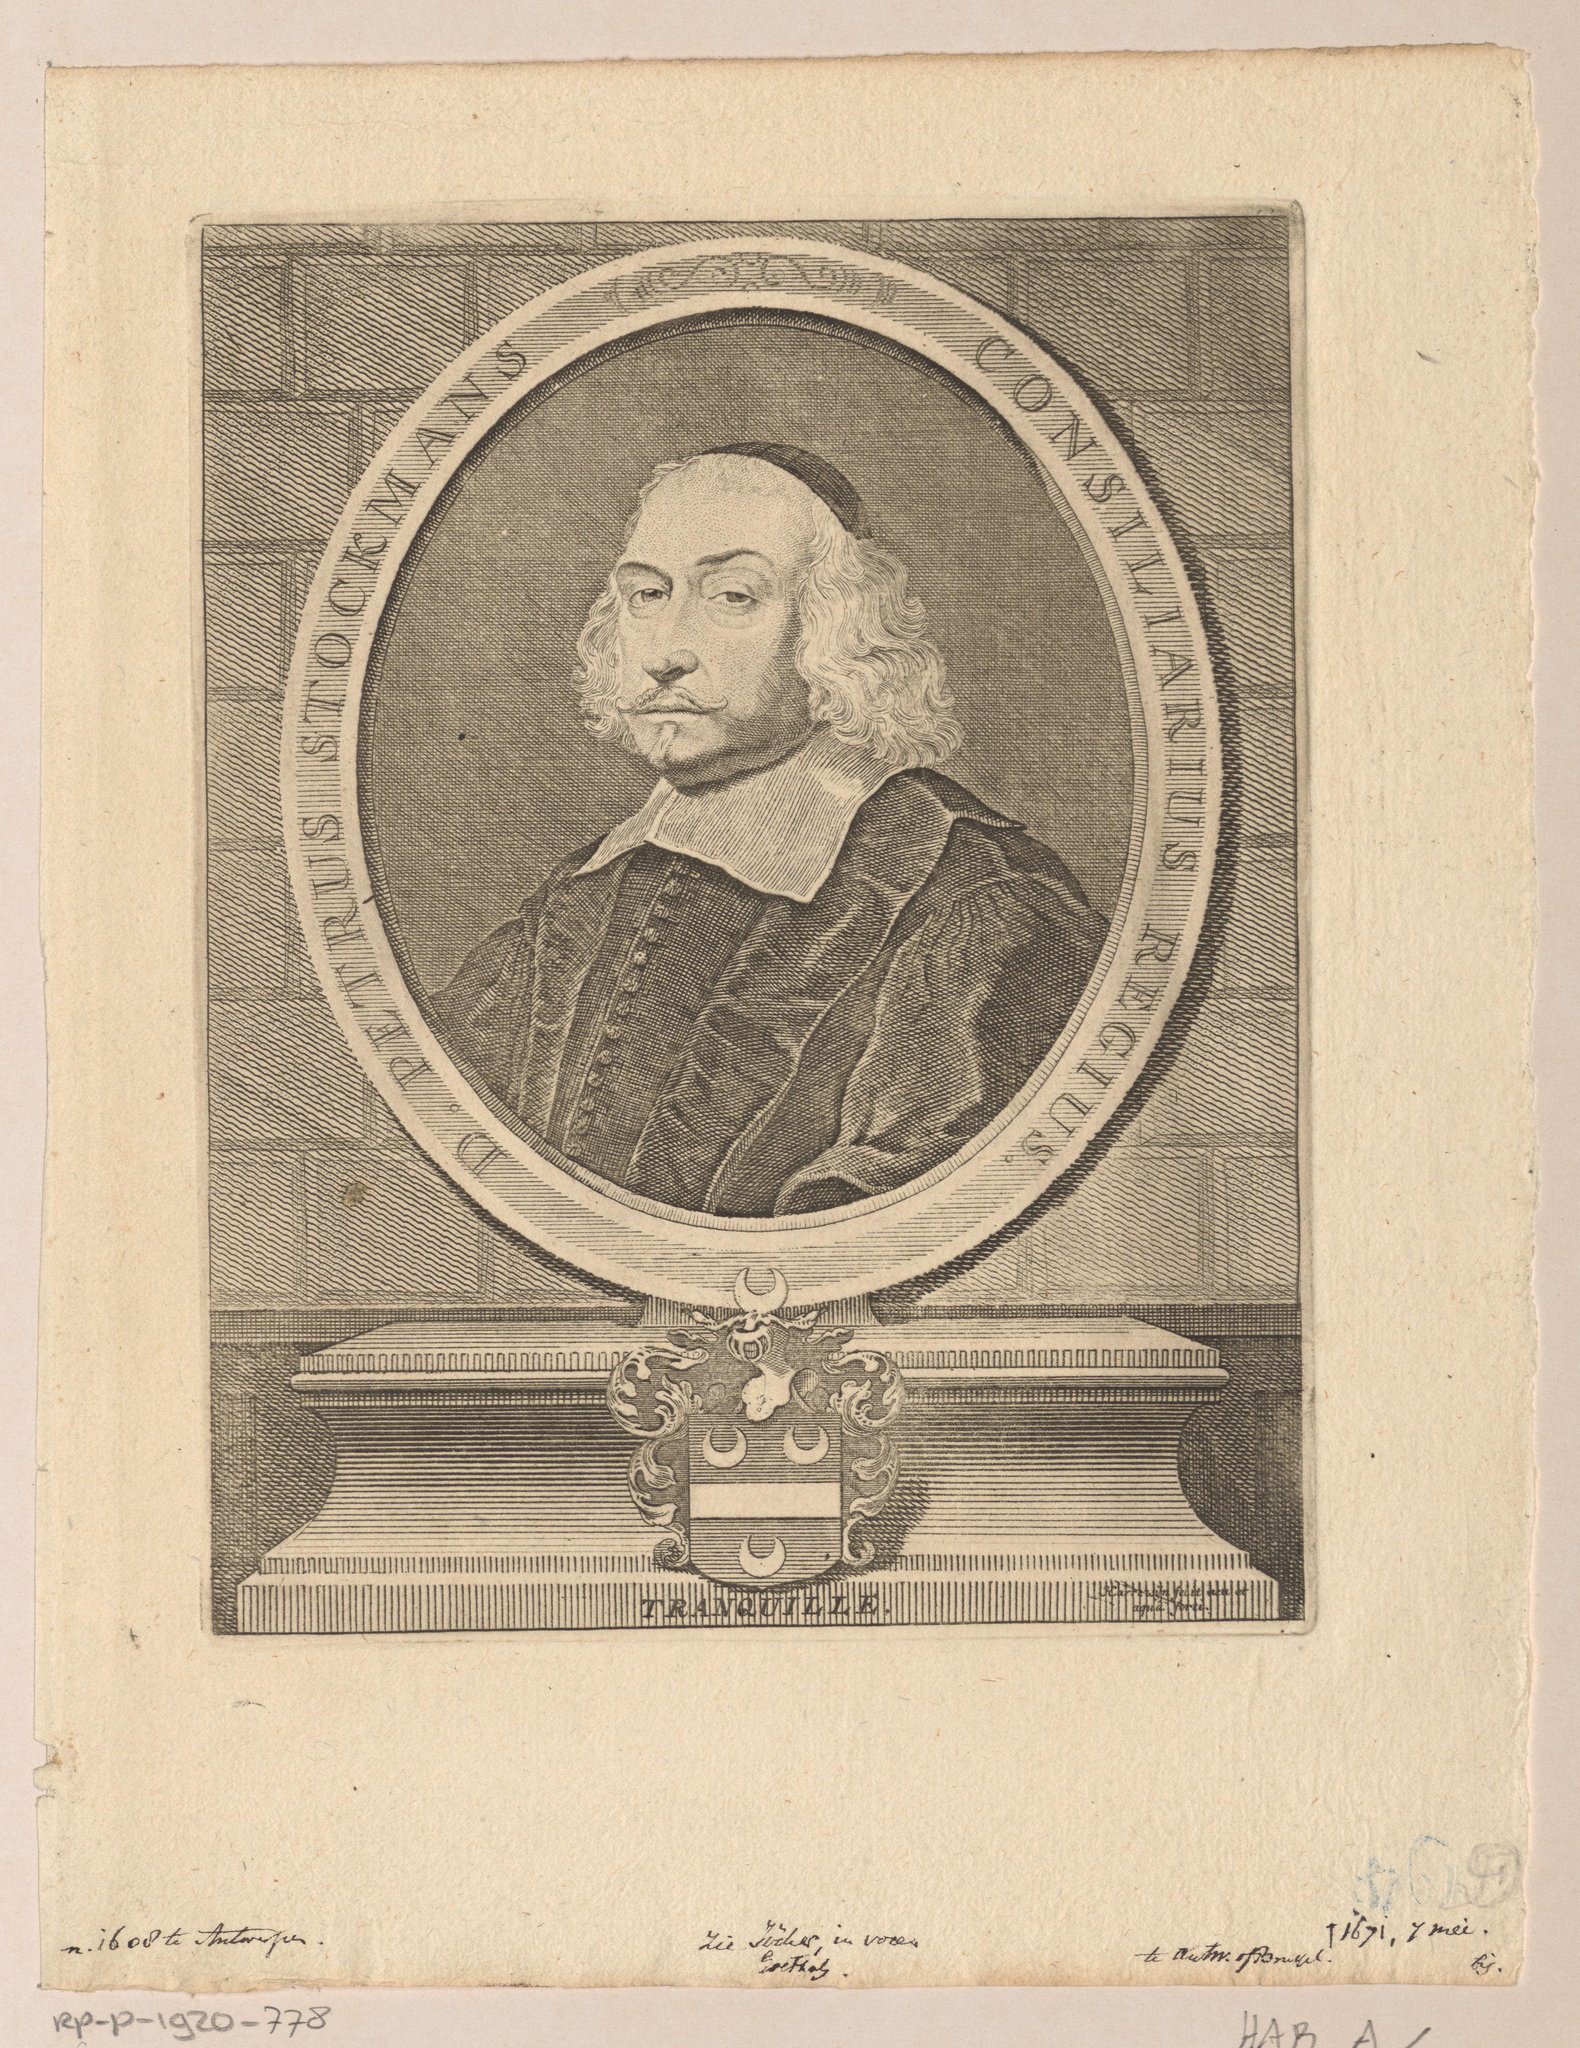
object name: print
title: Portret van Petrus Stockmans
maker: jacobus harrewijn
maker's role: print maker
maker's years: 1660-1740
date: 1682-1732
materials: paper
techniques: etching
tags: historical persons, portrait of a writer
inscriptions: collector's mark: Lugt 2228, inscription: ‘n. 1608 te Antwerpen. / Zie Zücker in vo[...] / te [...]utw. of Brussel + 1671, 7 mei.’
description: Met tekst in het Latijn rondom het portret.